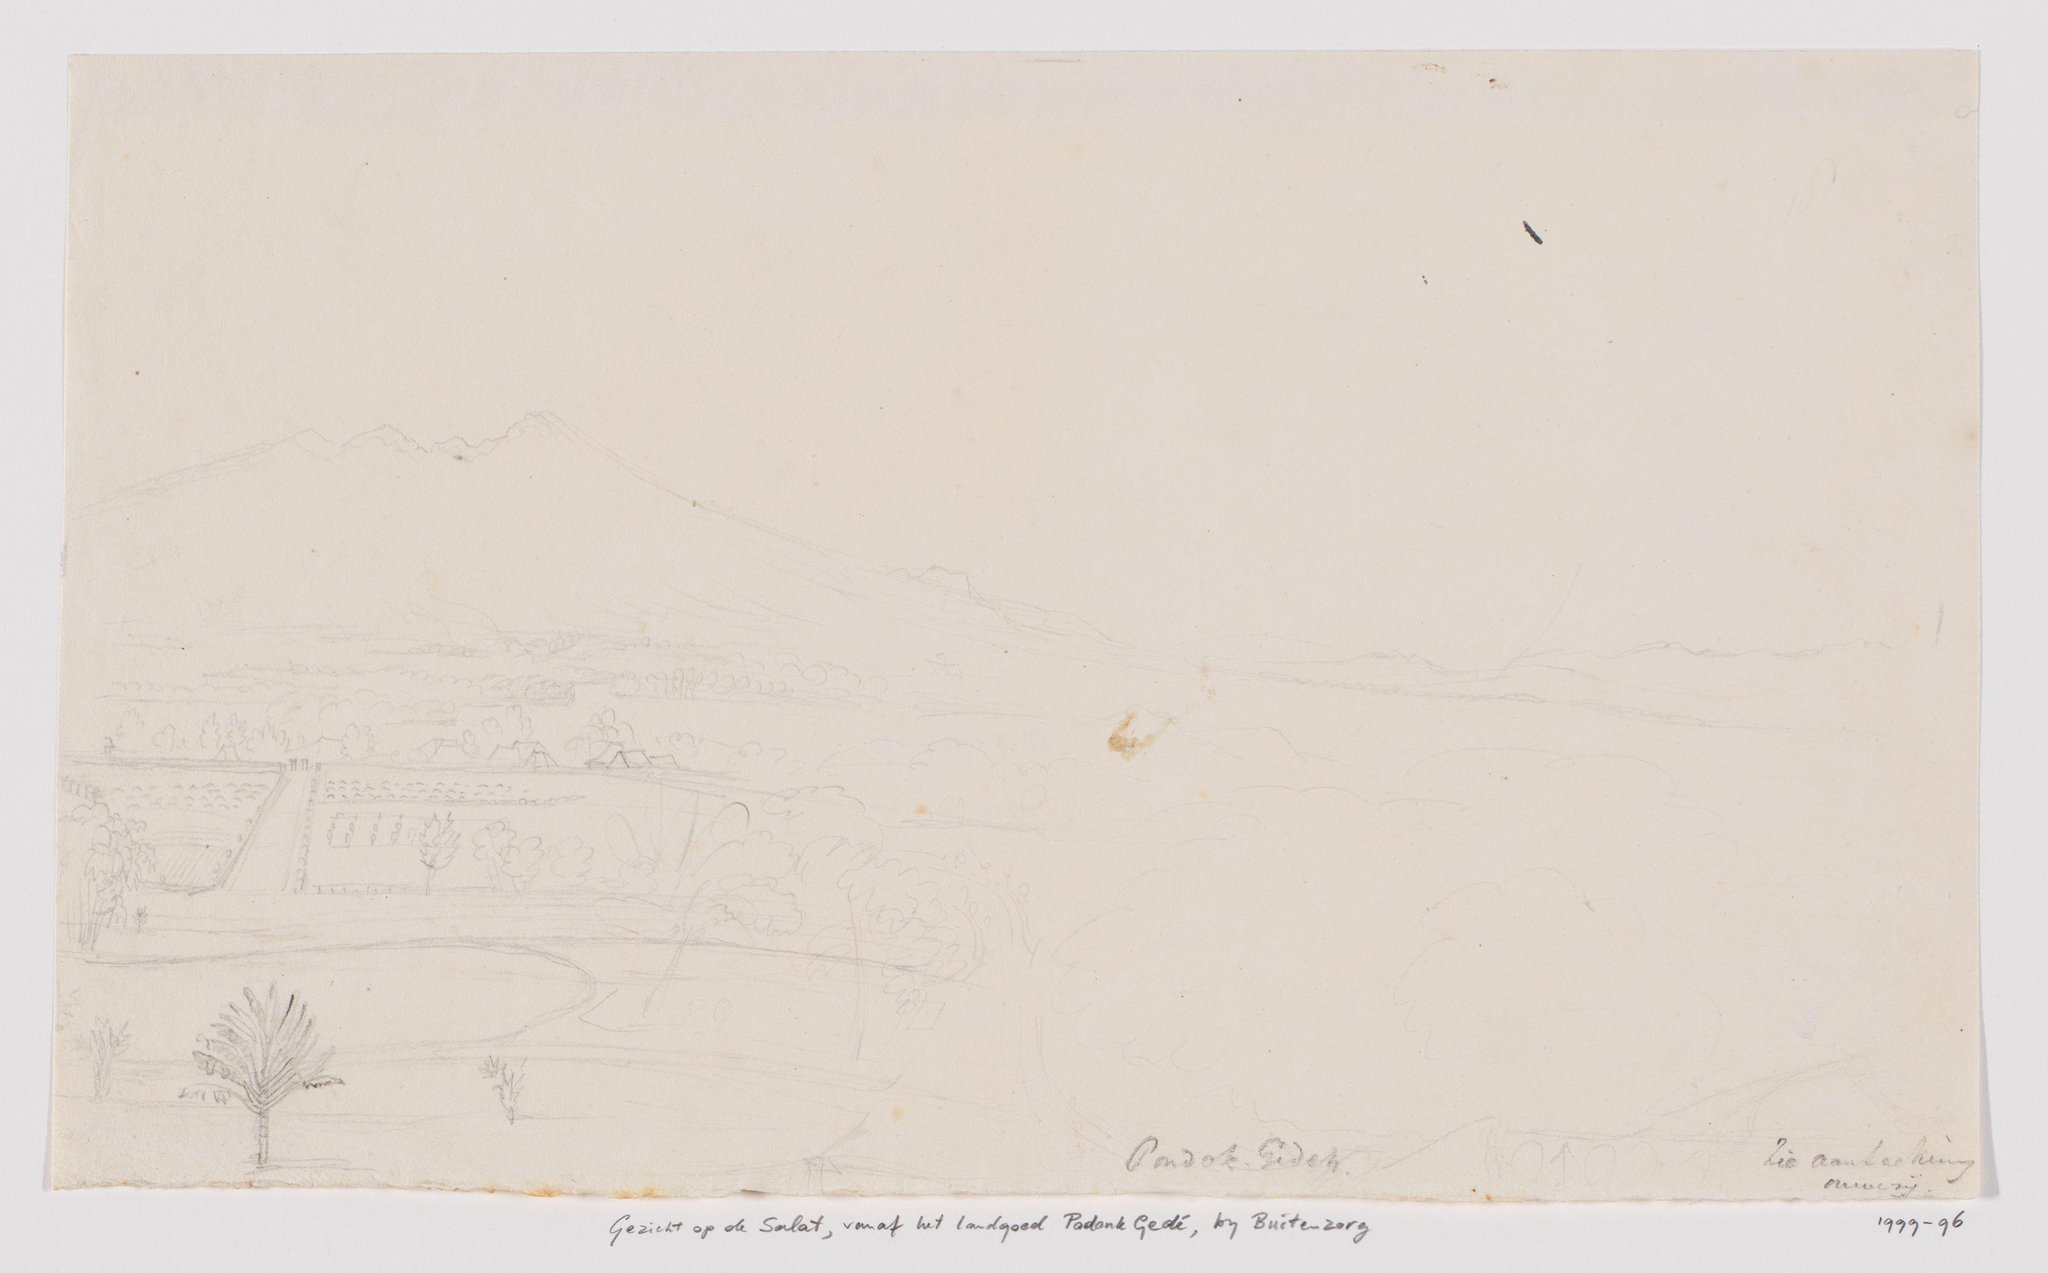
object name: topographical view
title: Gezicht op de Salak vanuit Pondok Gedé (?), West-Java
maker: adrianus johannes bik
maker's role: draughtsman, print maker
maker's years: 1790-1872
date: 1816-1846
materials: paper, pencil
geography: west java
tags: west-java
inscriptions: inscription: ‘ik geloof dat dit/ een gezigt is van/ Pondok Gedé, op de Sallak./ THB[?]’, inscription: ‘Pondok Gedeh’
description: artikel over deze collectie in Bulletin van het Rijksmuseum 49 [2001], nr. 4, pp 342 e.v.